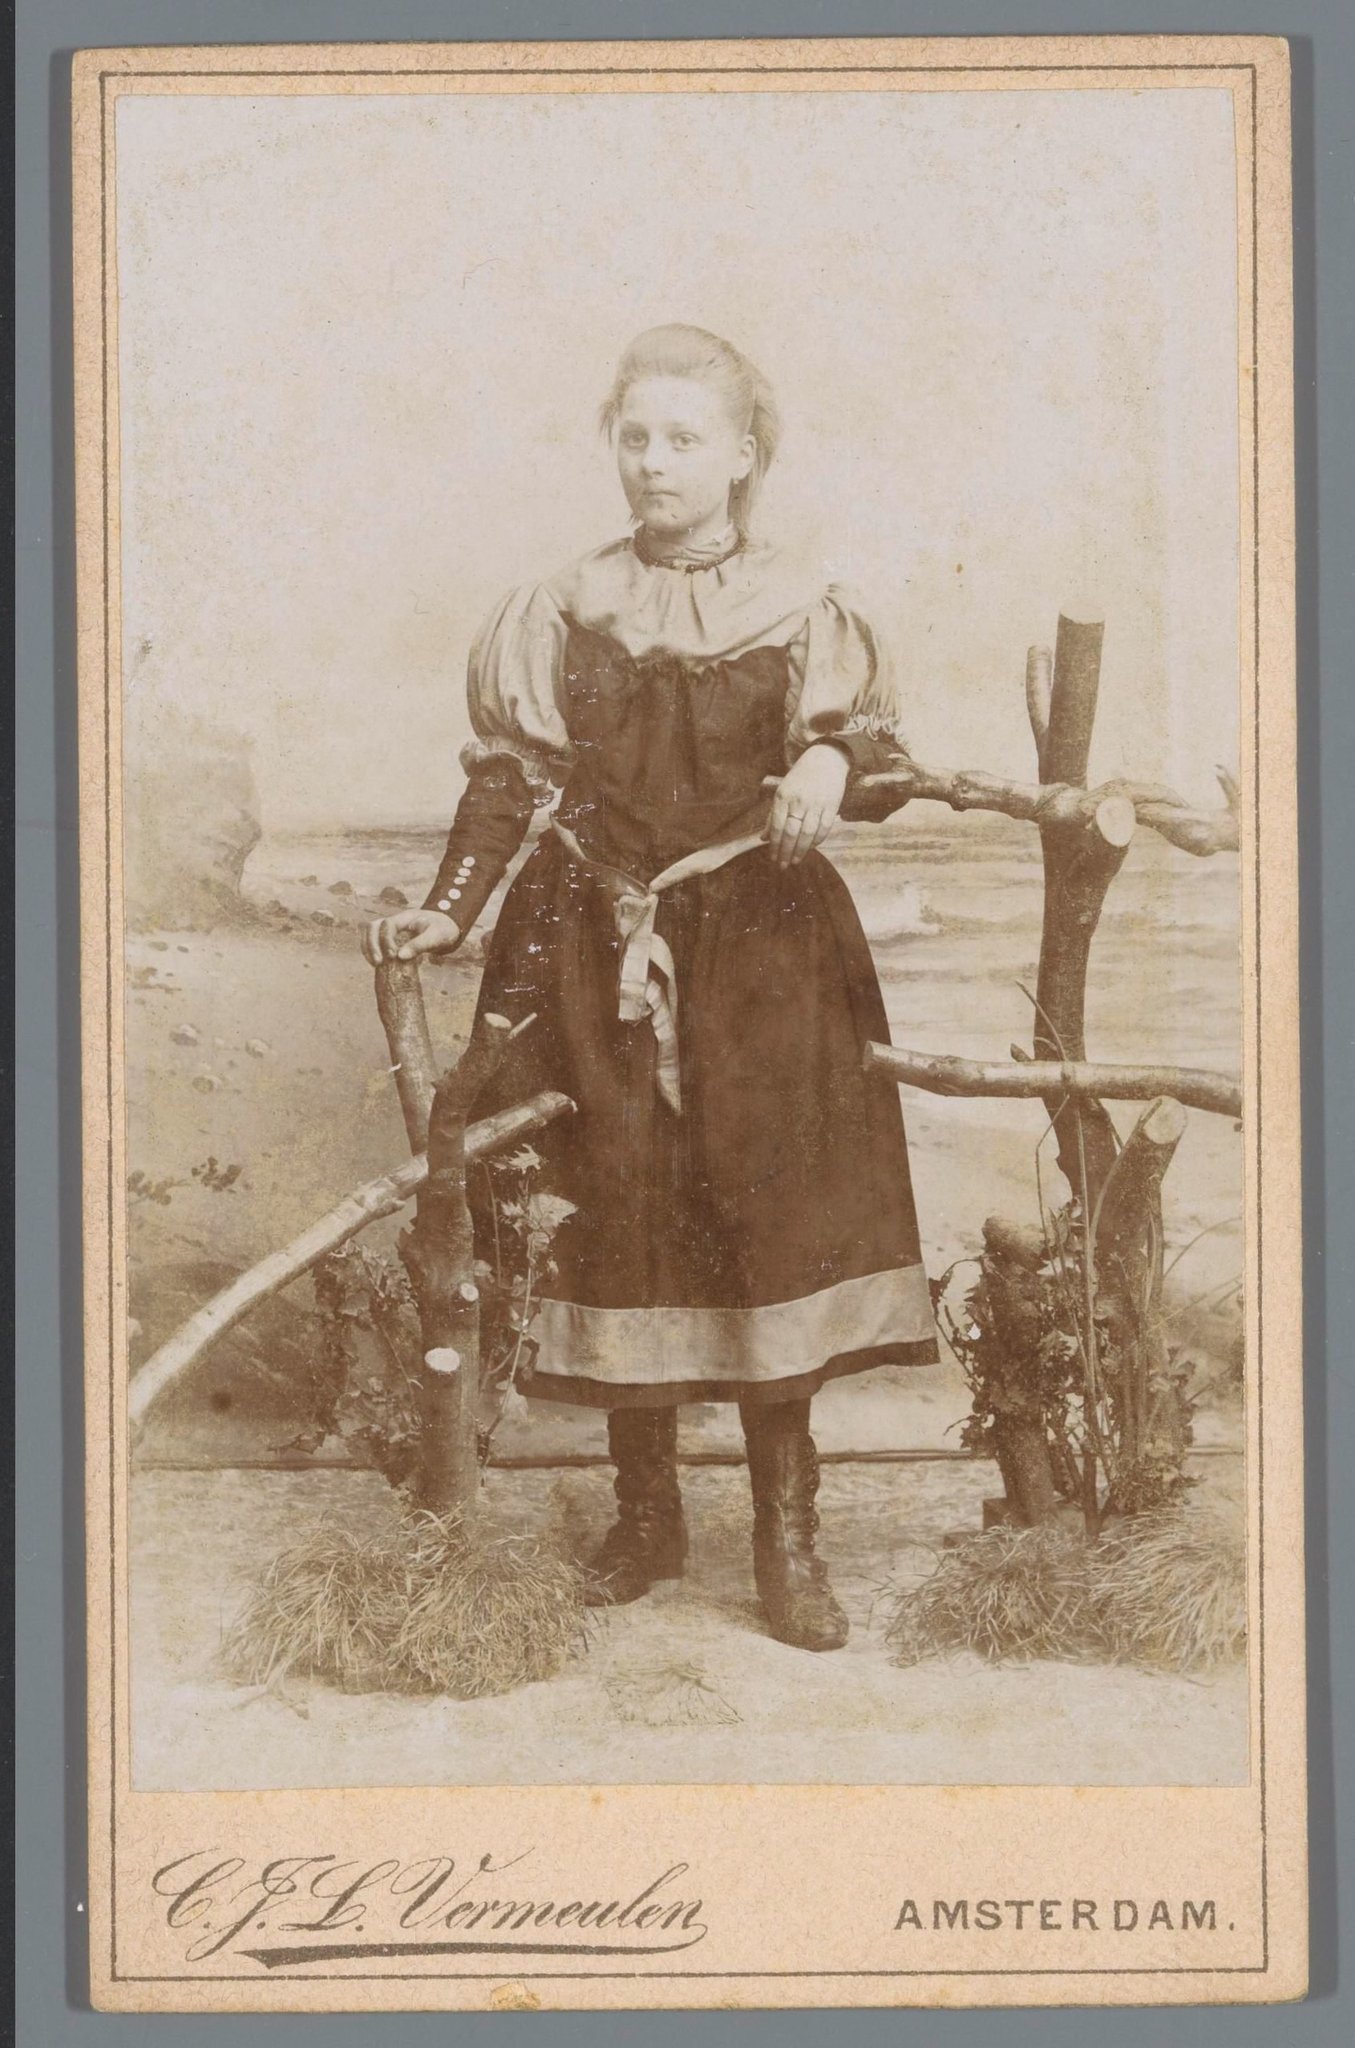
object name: photograph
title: Portret van een onbekend meisje bij een hek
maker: cornelis johannes lodewicus vermeulen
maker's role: fotograaf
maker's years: 1861-1936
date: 1888-1896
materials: paper, cardboard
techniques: collodion silver print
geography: amsterdam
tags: girl (child between toddler and youth), anonymous historical person portrayed, amsterdam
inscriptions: inscription: ‘C.J.L. Vermeulen Amsterdam.’, inscription: ‘Photographische/ Ateliers/ C.J.L. Vermeuelen/ Heerenstraat 6,/ &/ Heiligenweg/ hoek Singel/ Amsterdam./ Specialiteit in vergrootingen.’